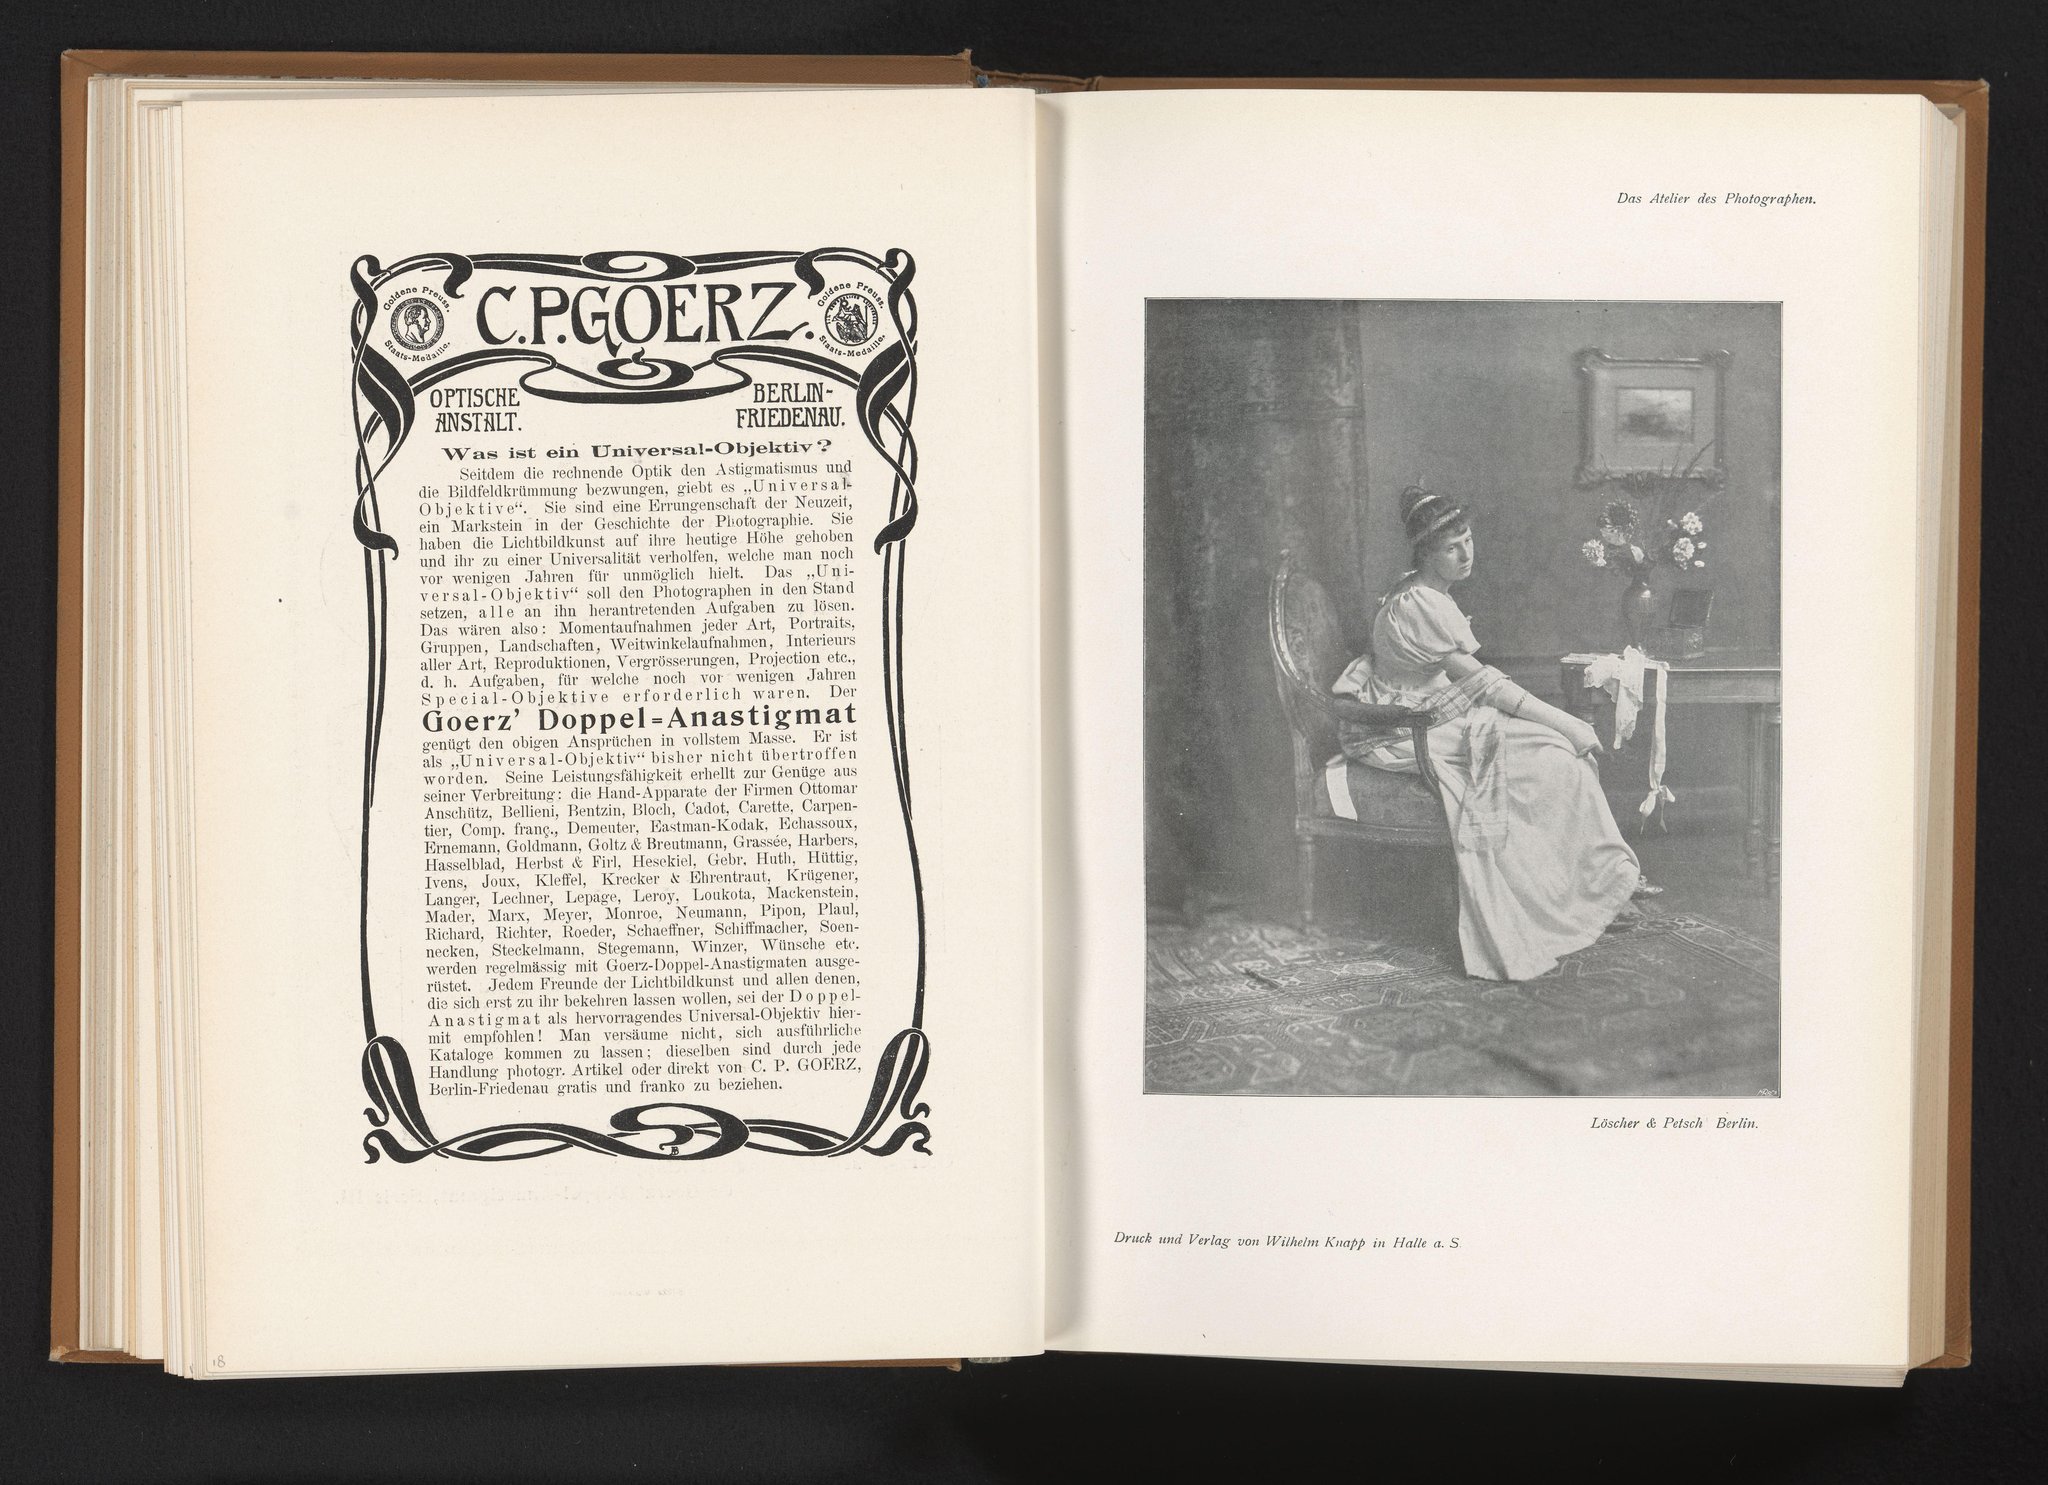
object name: page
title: Portret van een onbekende vrouw op een stoel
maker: wilhelm knapp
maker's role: publisher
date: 1895-1900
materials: paper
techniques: autotype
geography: halle an der saale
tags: historical persons - bb - woman, chair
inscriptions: inscription: ‘Das Atelier des Photographen.’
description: Prent op derde ongenummerde pagina na pagina 72.